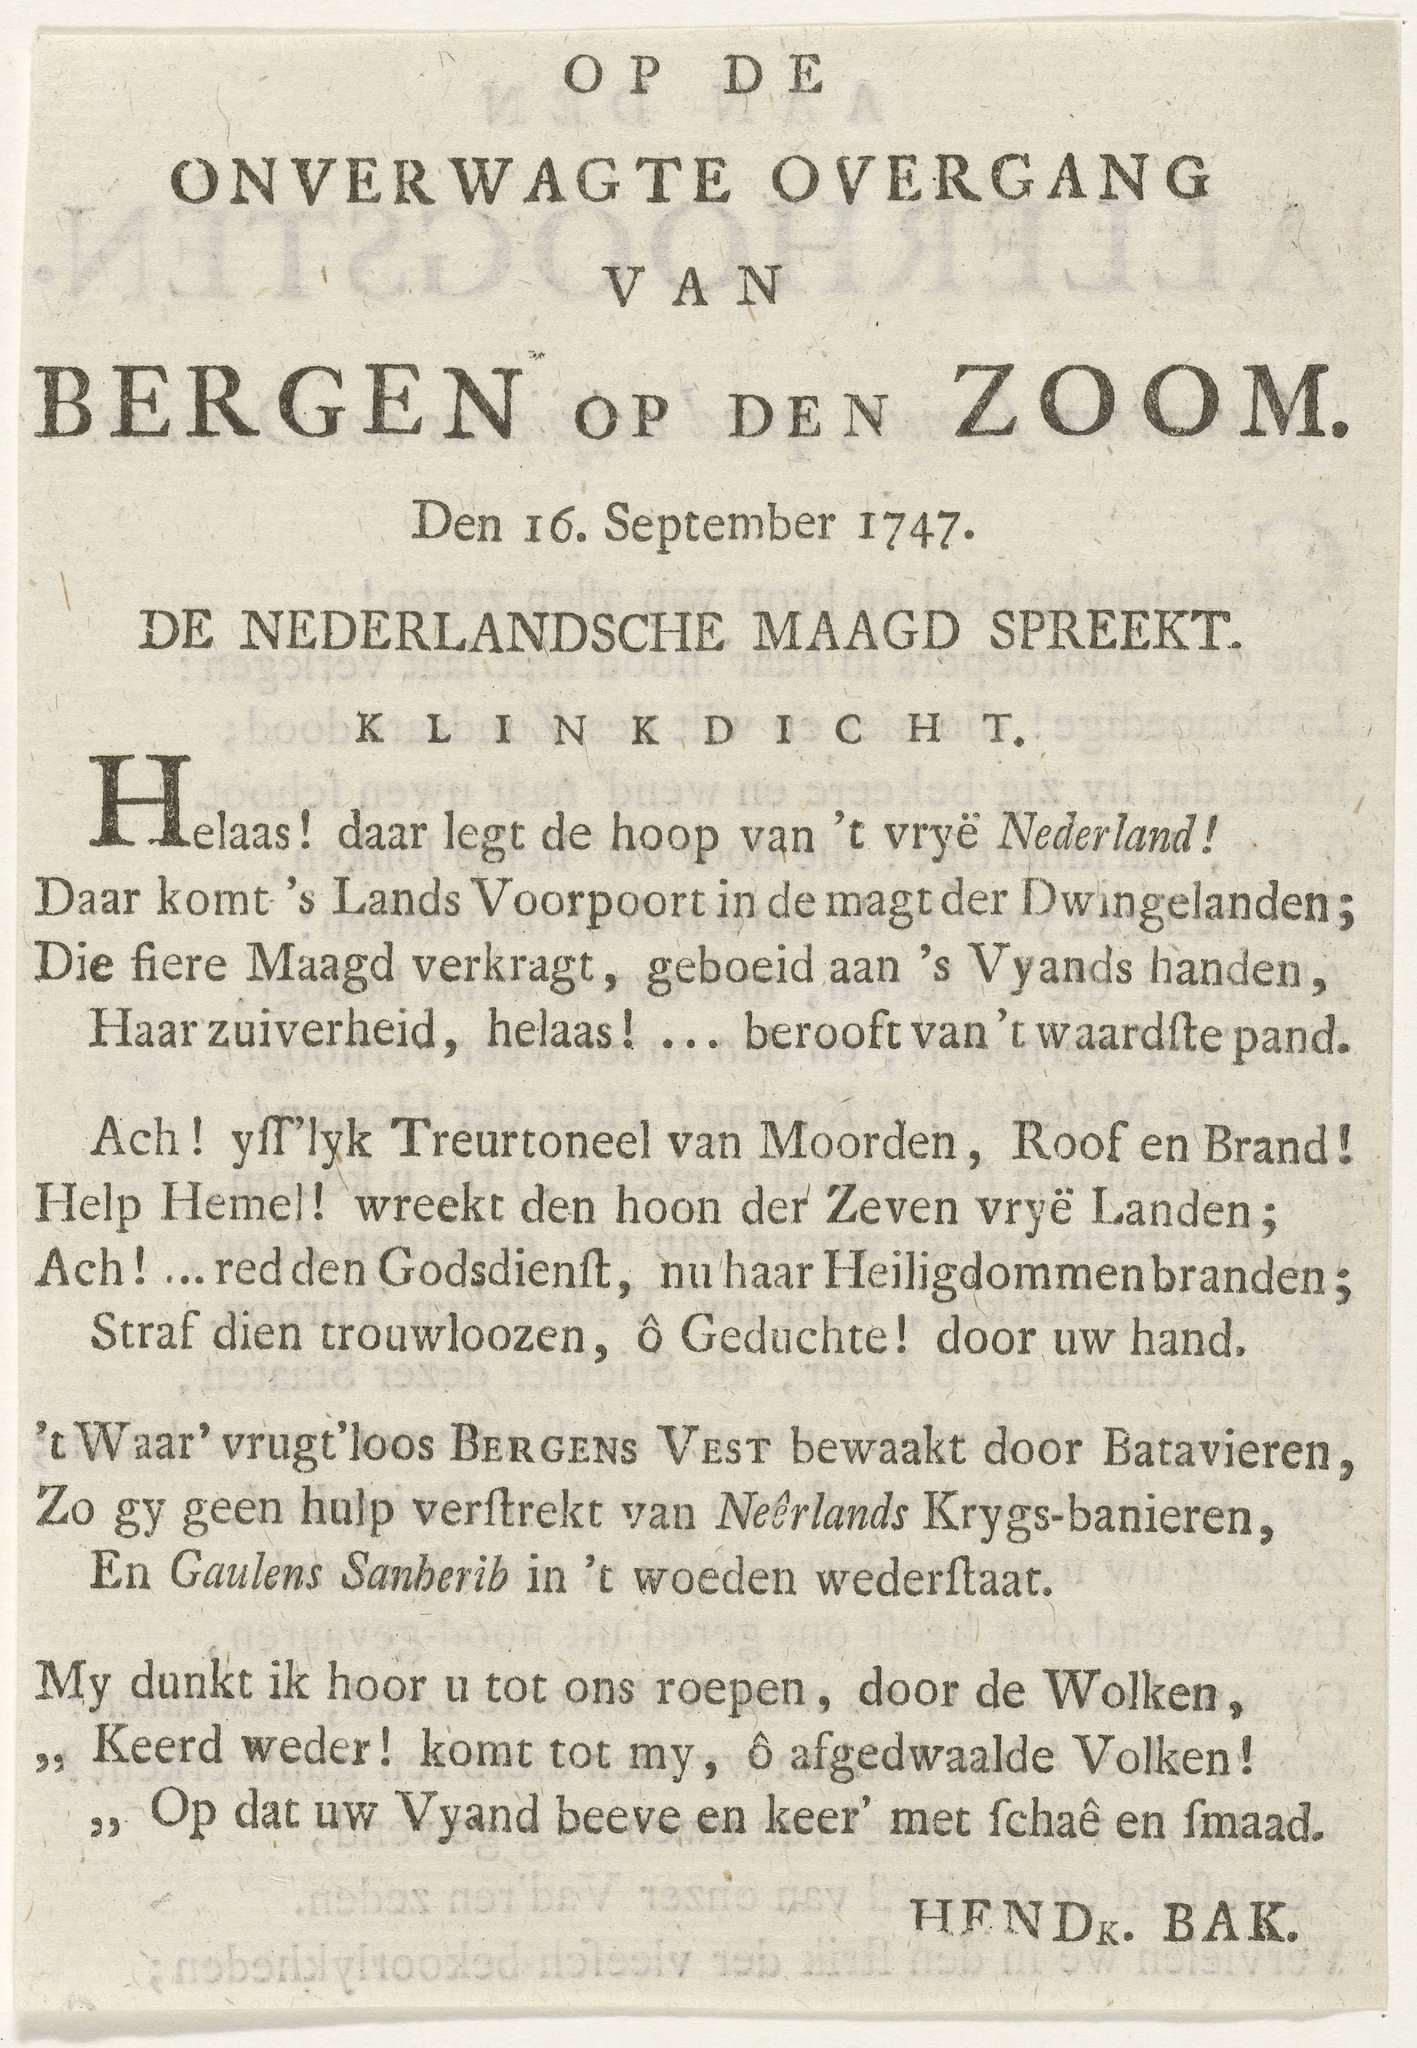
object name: text sheet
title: Vers op de val van Bergen op Zoom, 1747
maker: hendrik bak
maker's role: schrijver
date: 1747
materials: paper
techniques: letterpress printing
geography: northern netherlands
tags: bergen op zoom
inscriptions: collector's mark: Lugt 2228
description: Tekstblad met een klinkdicht op het beleg en de val van Bergen op Zoom door de Fransen in juli-september 1747. Blad genomen uit een boek en op beide zijden bedrukt.